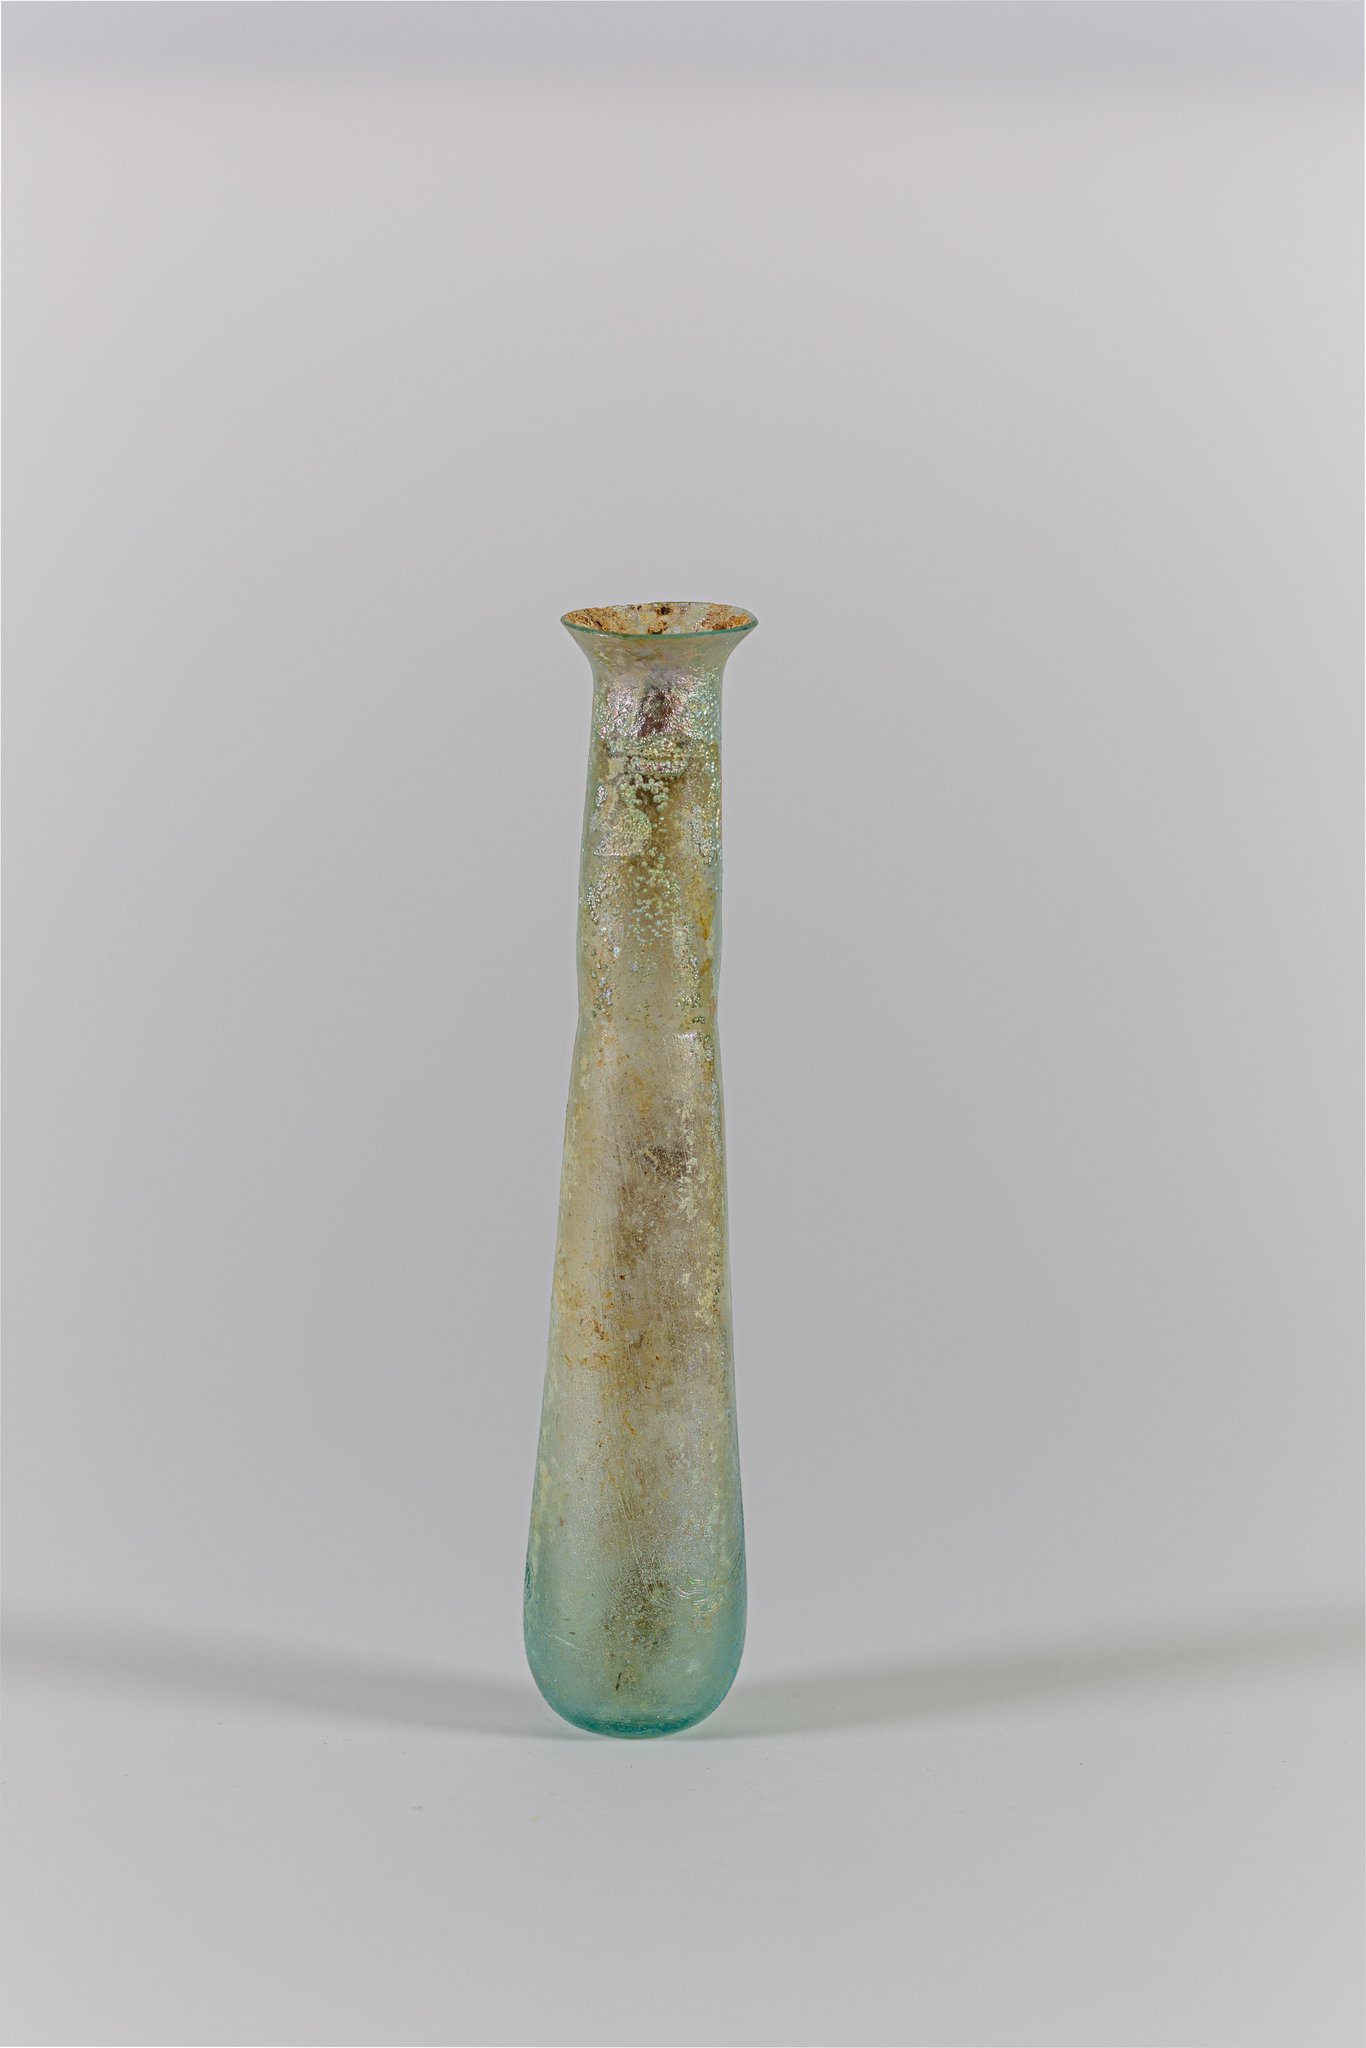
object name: bottle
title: Glass perfume bottle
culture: roman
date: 34-133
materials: glass